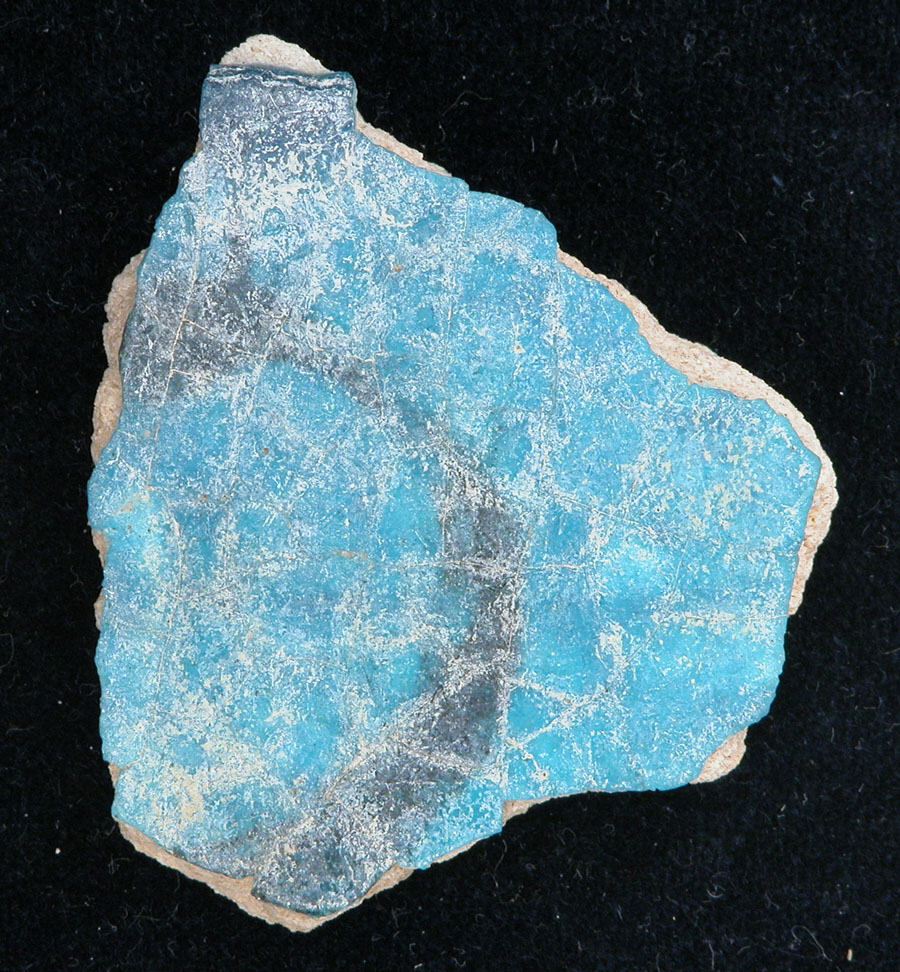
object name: fragment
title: Ceramic Fragment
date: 1101-1300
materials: stonepaste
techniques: painting, underglaze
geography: saudi arabia